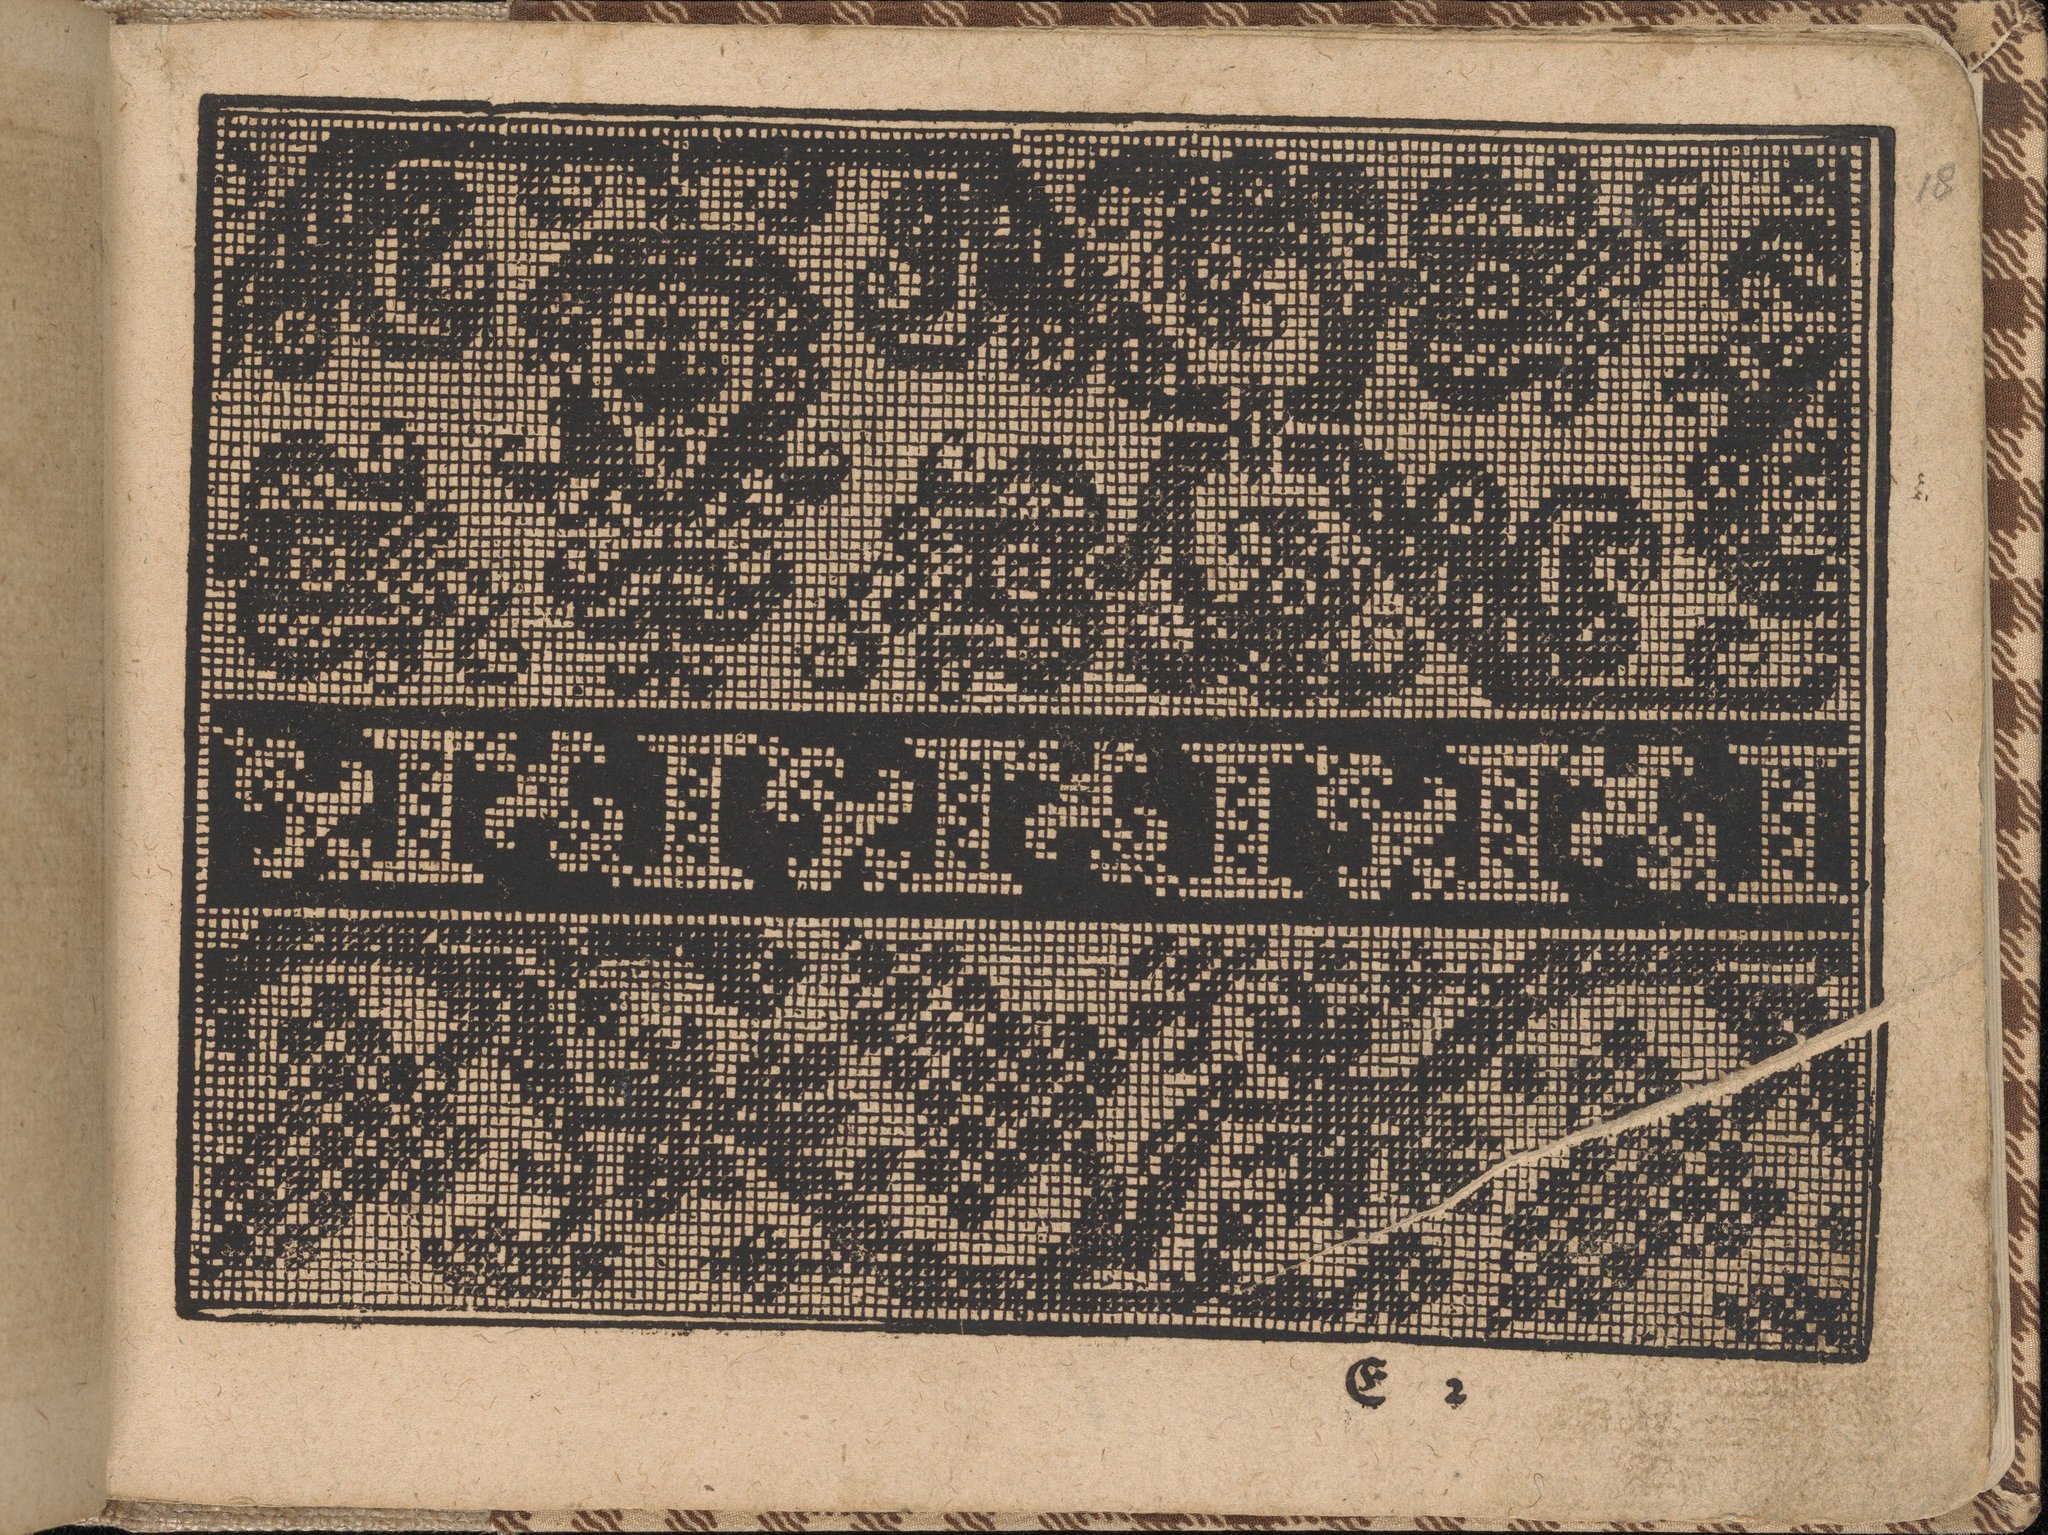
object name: book print ornament architecture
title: New Künstlichs Modelbuch (Page 18 recto)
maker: bernhard jobin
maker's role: publisher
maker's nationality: swiss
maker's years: 1535-1597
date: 1600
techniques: woodcut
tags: flowers